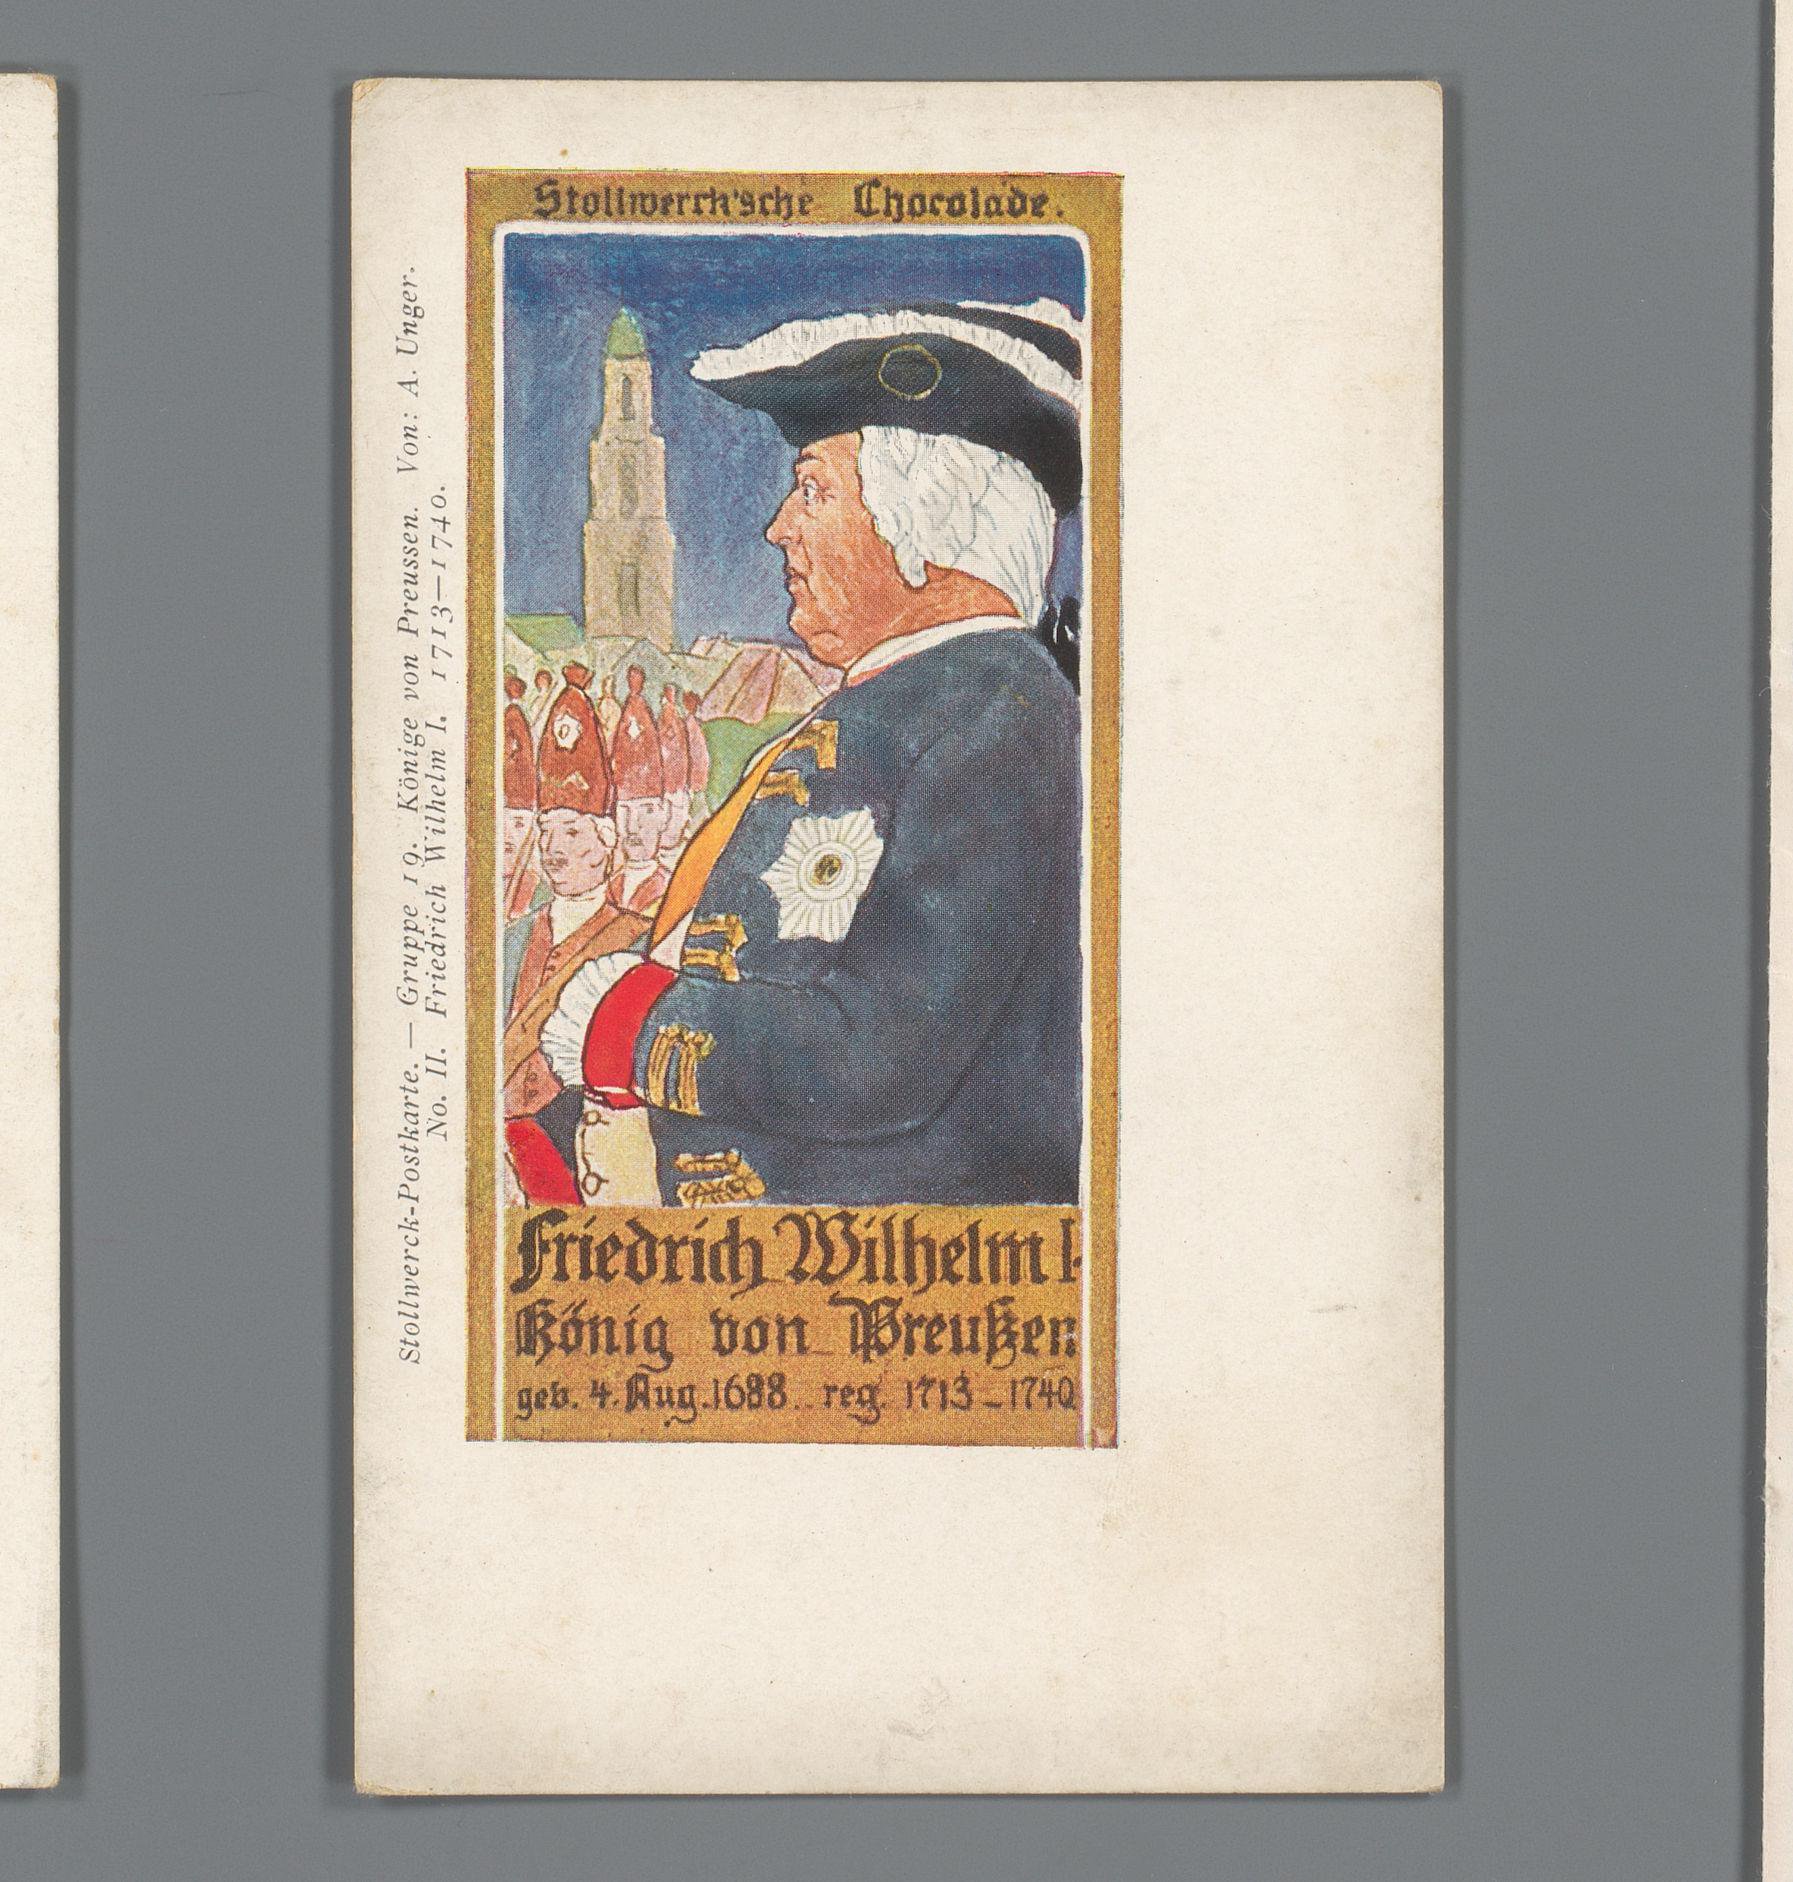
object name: photomechanical print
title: Friedrich Wilhelm I. 1713-1740 / Stollwerck-Postkarten - Gruppe 19. Könige von Preussen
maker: a. unger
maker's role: designer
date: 1905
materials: paper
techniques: autotype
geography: germany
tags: berlin, advertising, chocolate (solid), historical persons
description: Reclamekaart van Stollwercksche Chocolade: portret van Friedrich Wilhelm I, koning van Pruissen.